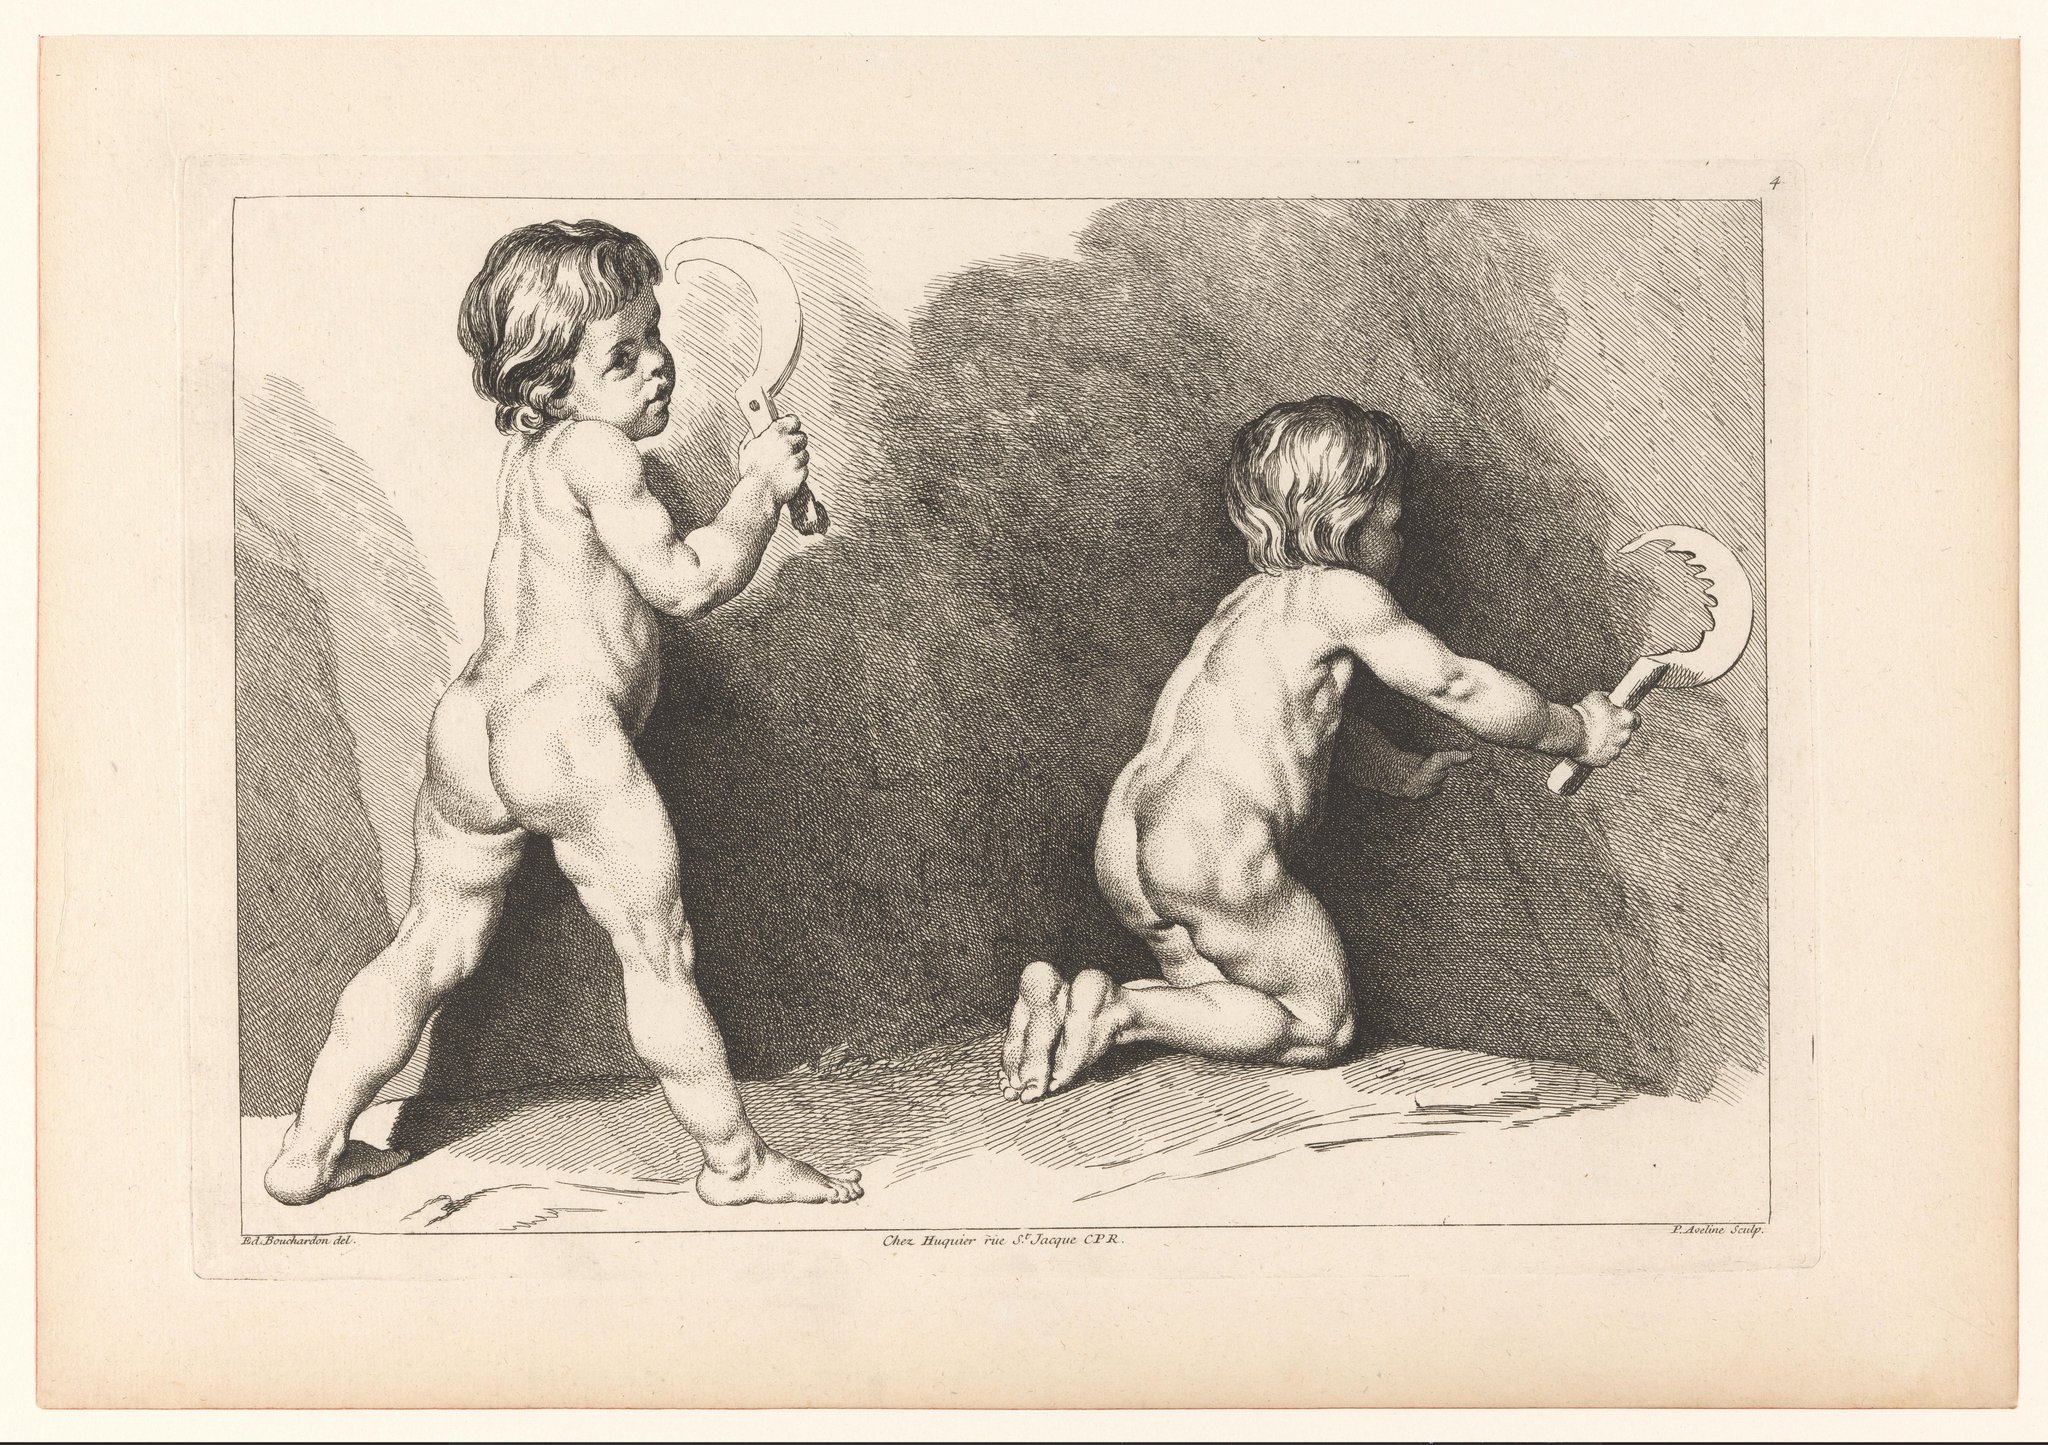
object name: print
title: Nouveau livre d’Enfants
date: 1742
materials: paper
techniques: etching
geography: paris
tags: standing figure (+ young male (human being)), kneeling figure (+ young male (human being)), agricultural implements: sickle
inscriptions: number: ‘4’, collector's mark: Lugt 2228, collector's mark: Lugt 2760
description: Twee jongetjes in de weer met een sikkel. Onderdeel van de serie studies van kinderen.